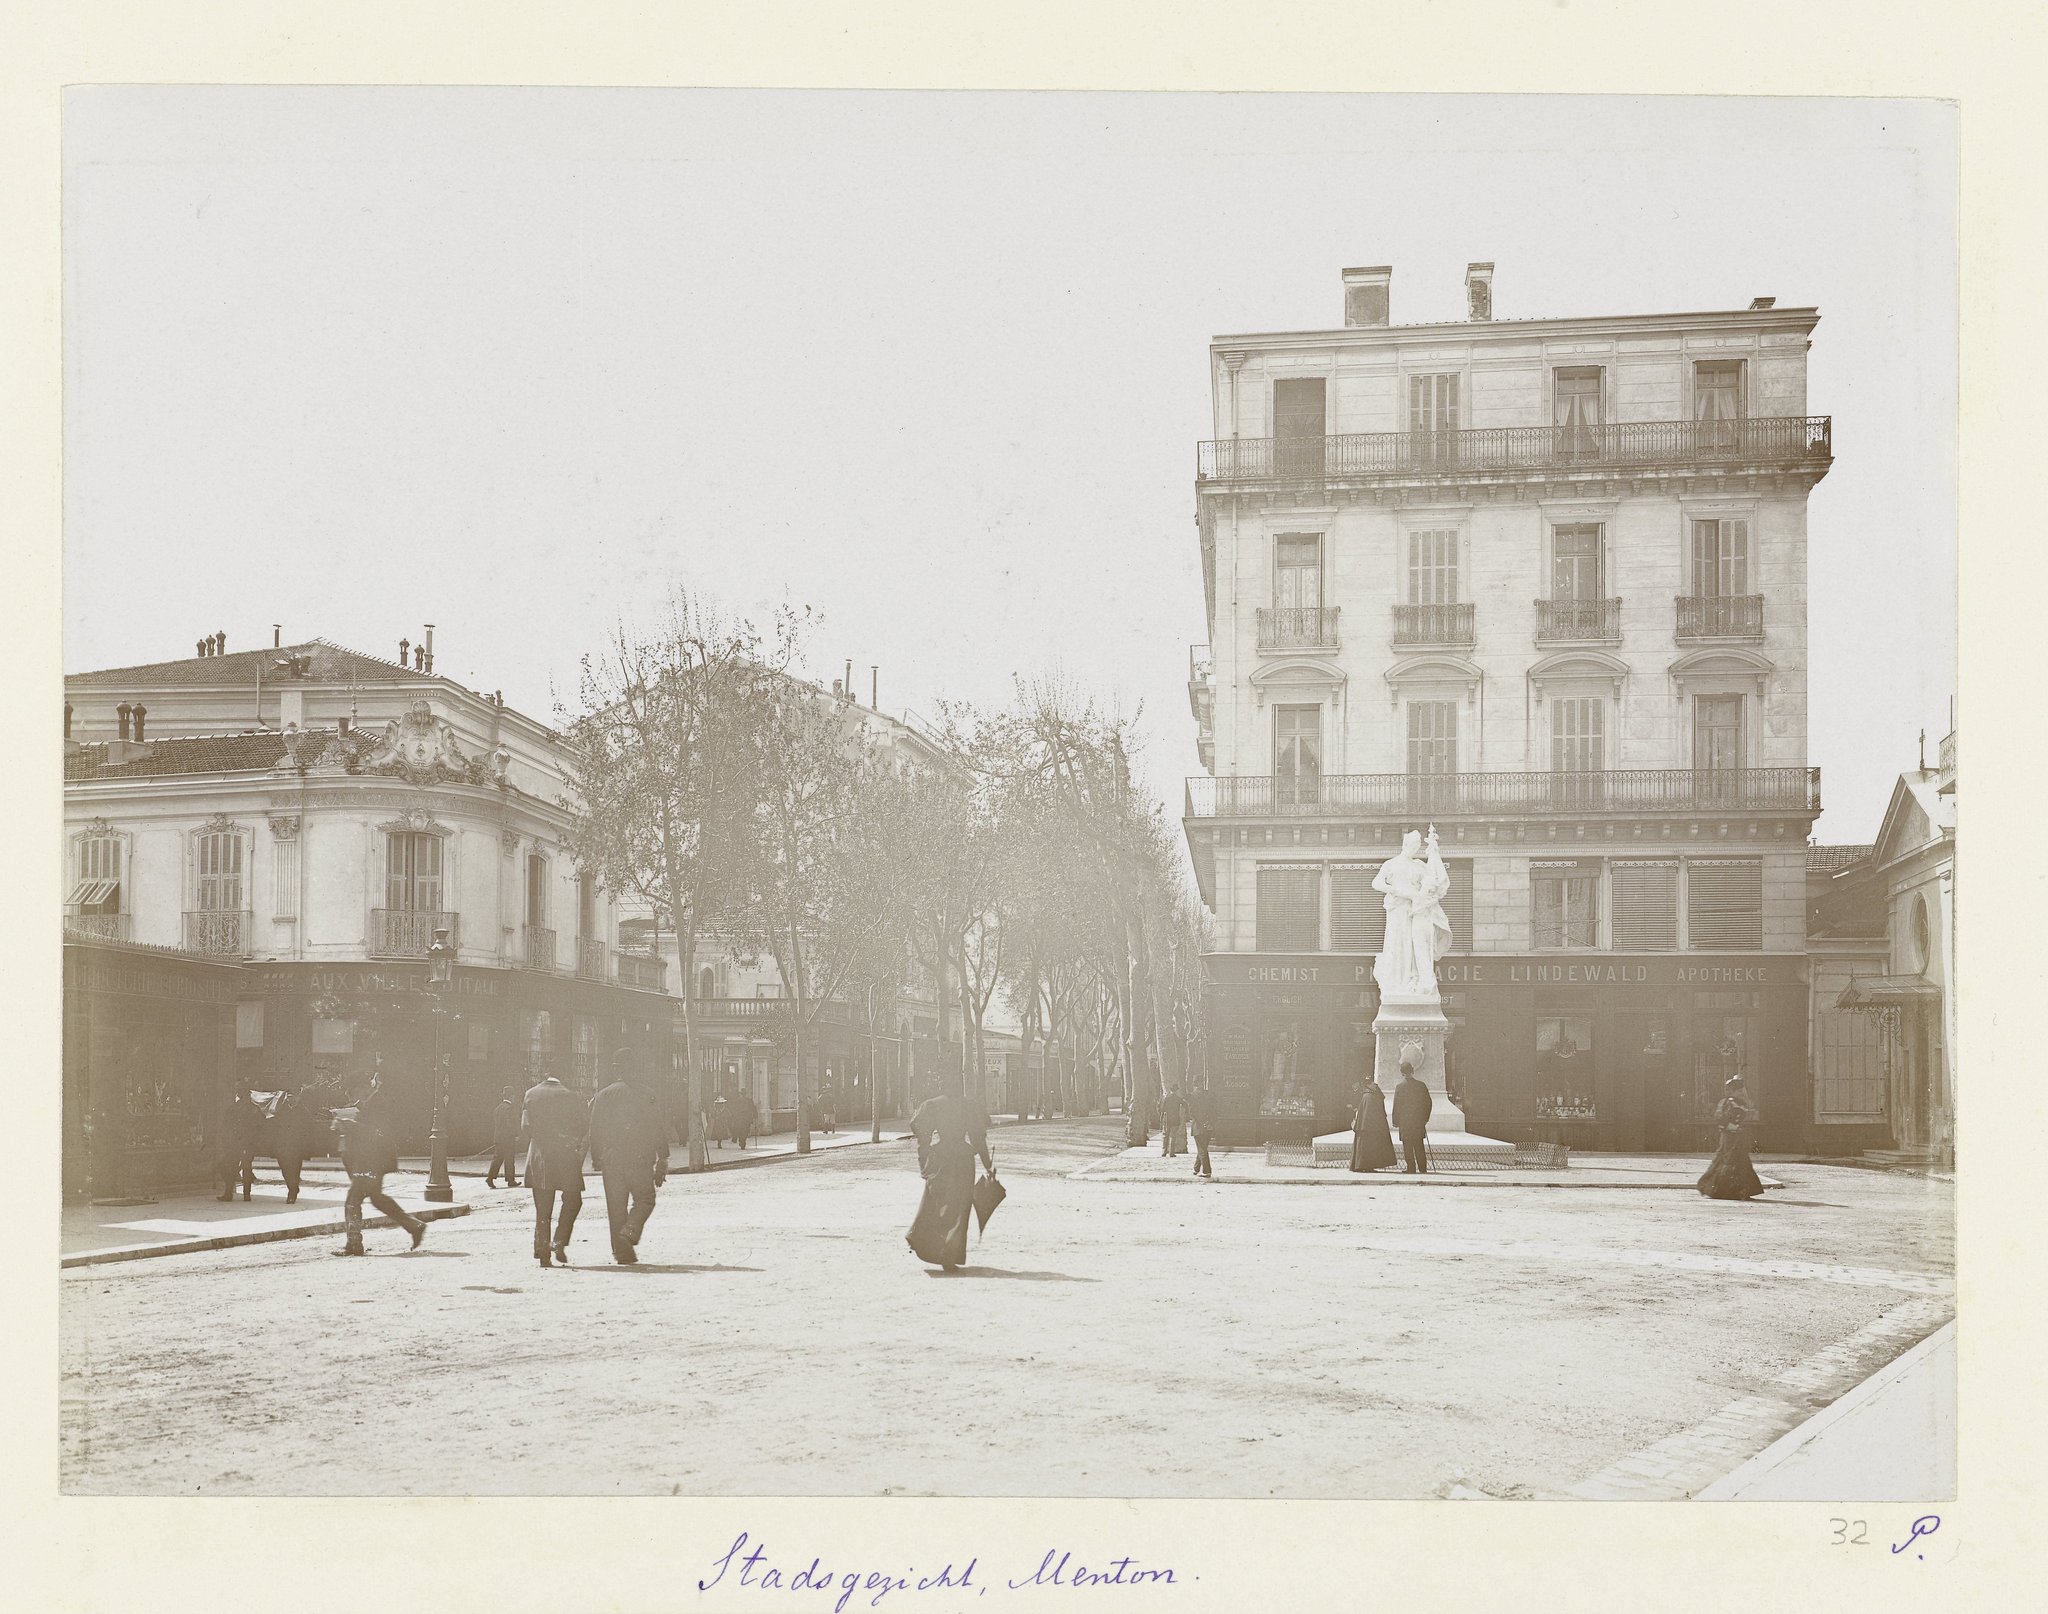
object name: photograph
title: Plein in Menton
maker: henry pauw van wieldrecht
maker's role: fotograaf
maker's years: 1863-1912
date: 1886-1896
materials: cardboard, photographic support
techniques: albumen print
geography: france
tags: menton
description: Een plein in de zuid-Franse stad Menton. Midden op het plein staat een standbeeld en op straat wandelen mensen, op de achtergrond laagbouw woningen.